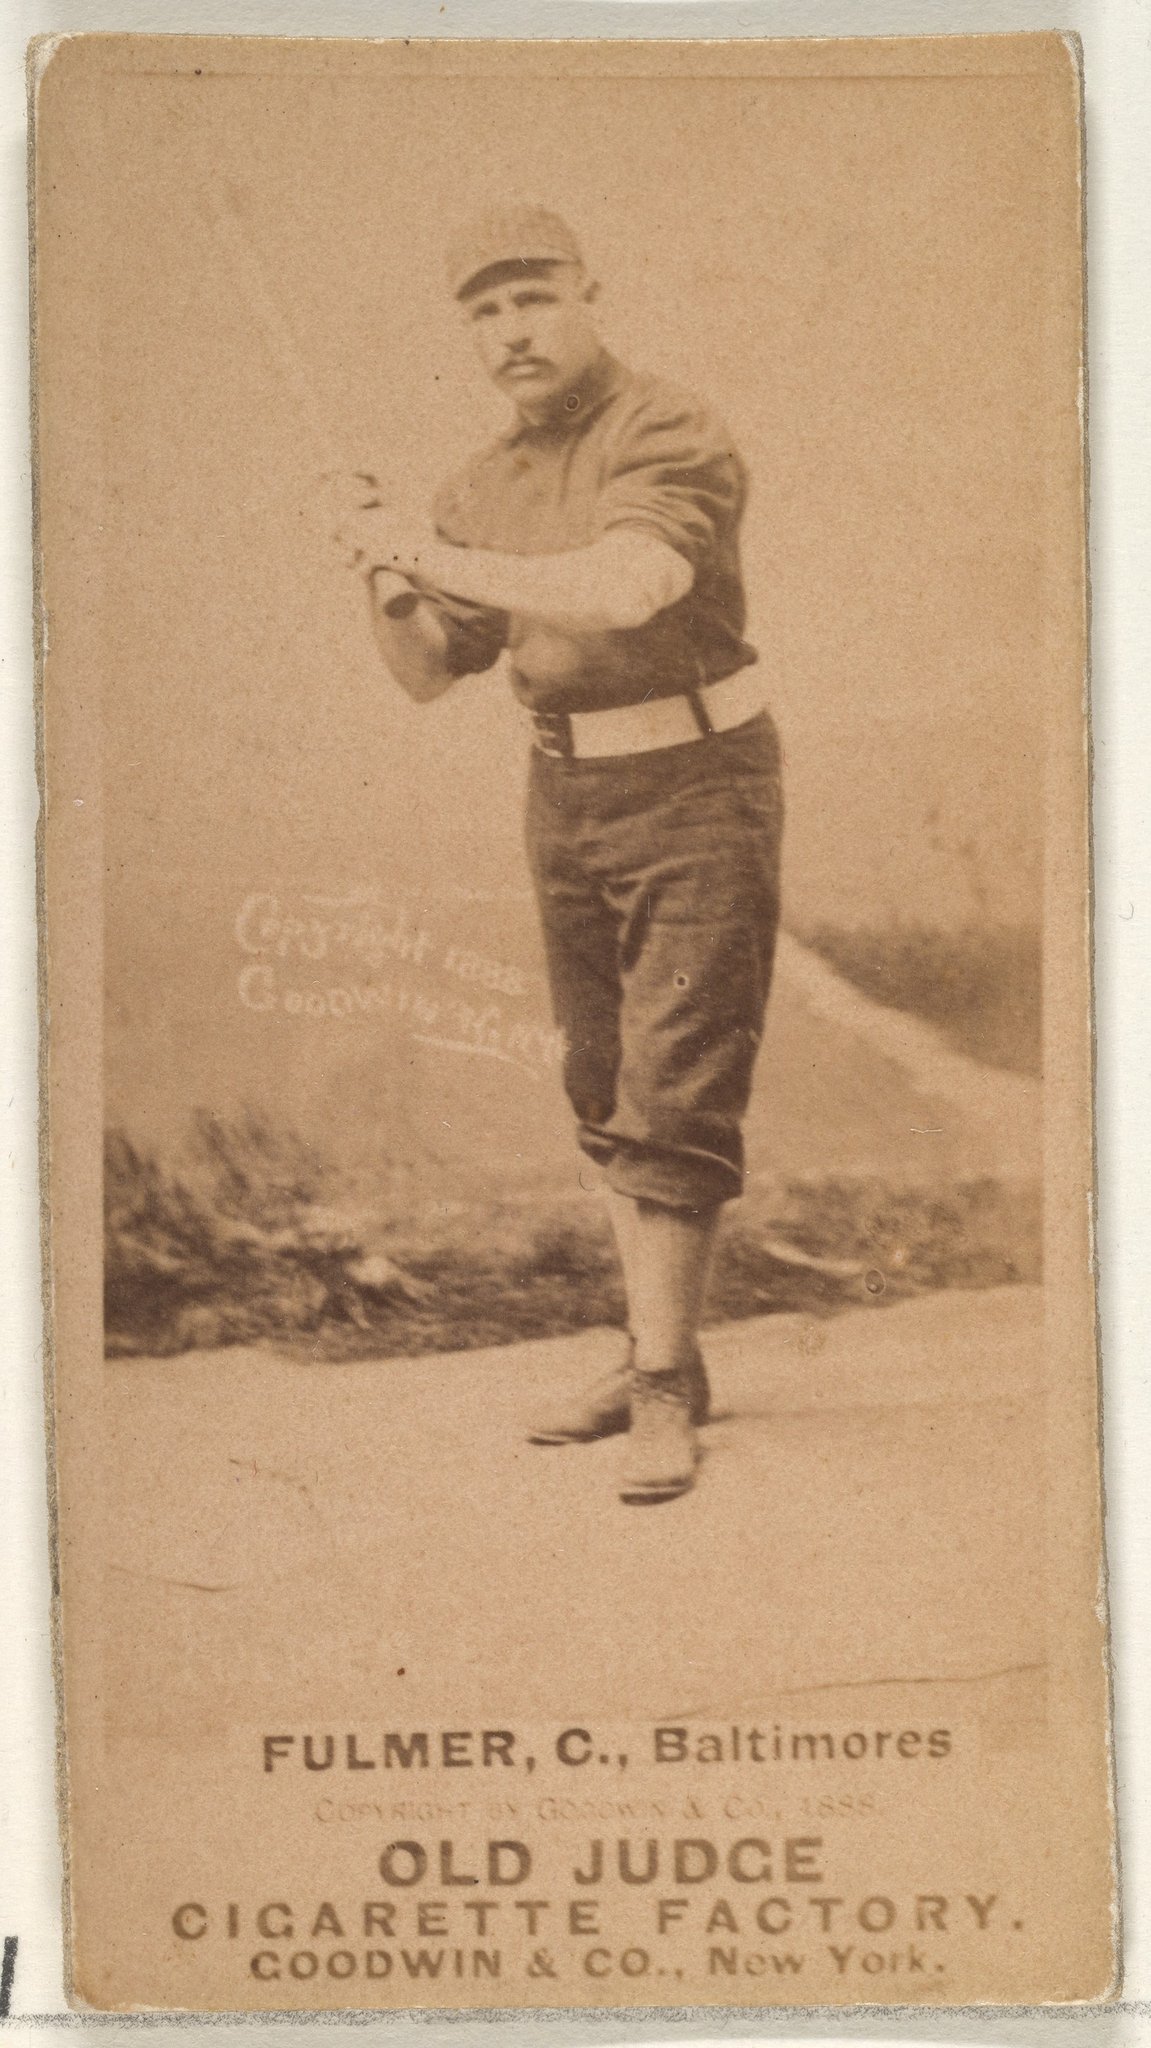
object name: baseball card, photograph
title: Fulmer, Catcher, Baltimore Orioles, from the Old Judge series (N172) for Old Judge Cigarettes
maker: goodwin & company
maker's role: publisher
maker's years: 1850-1950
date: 1888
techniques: albumen silver print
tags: men,portraits,baseball,athletes